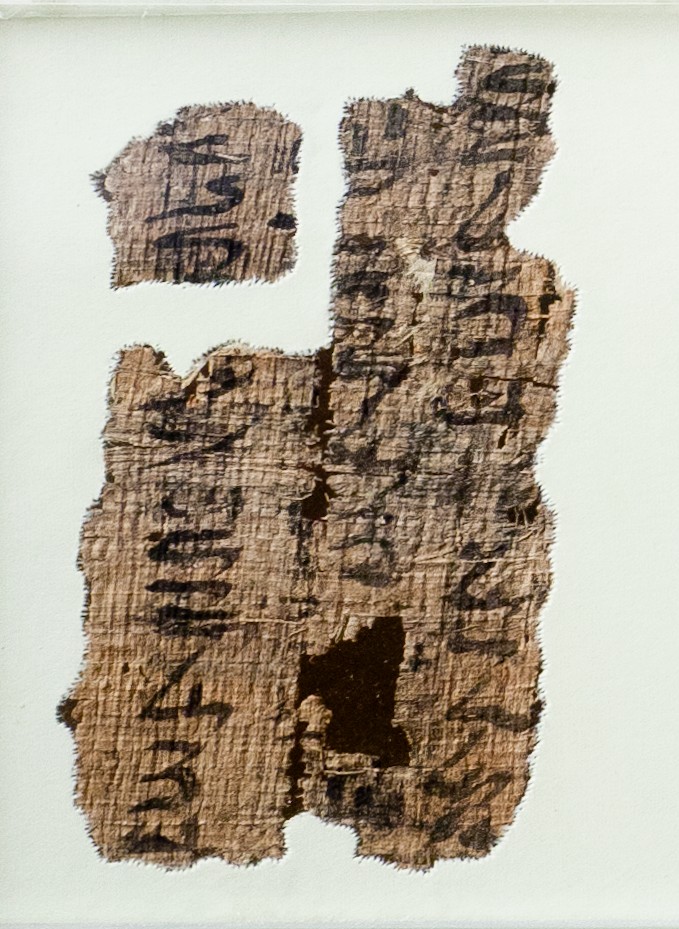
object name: papyrus, letter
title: Papyrus fragment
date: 2030-1640 BCE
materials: ink, papyrus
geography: egypt